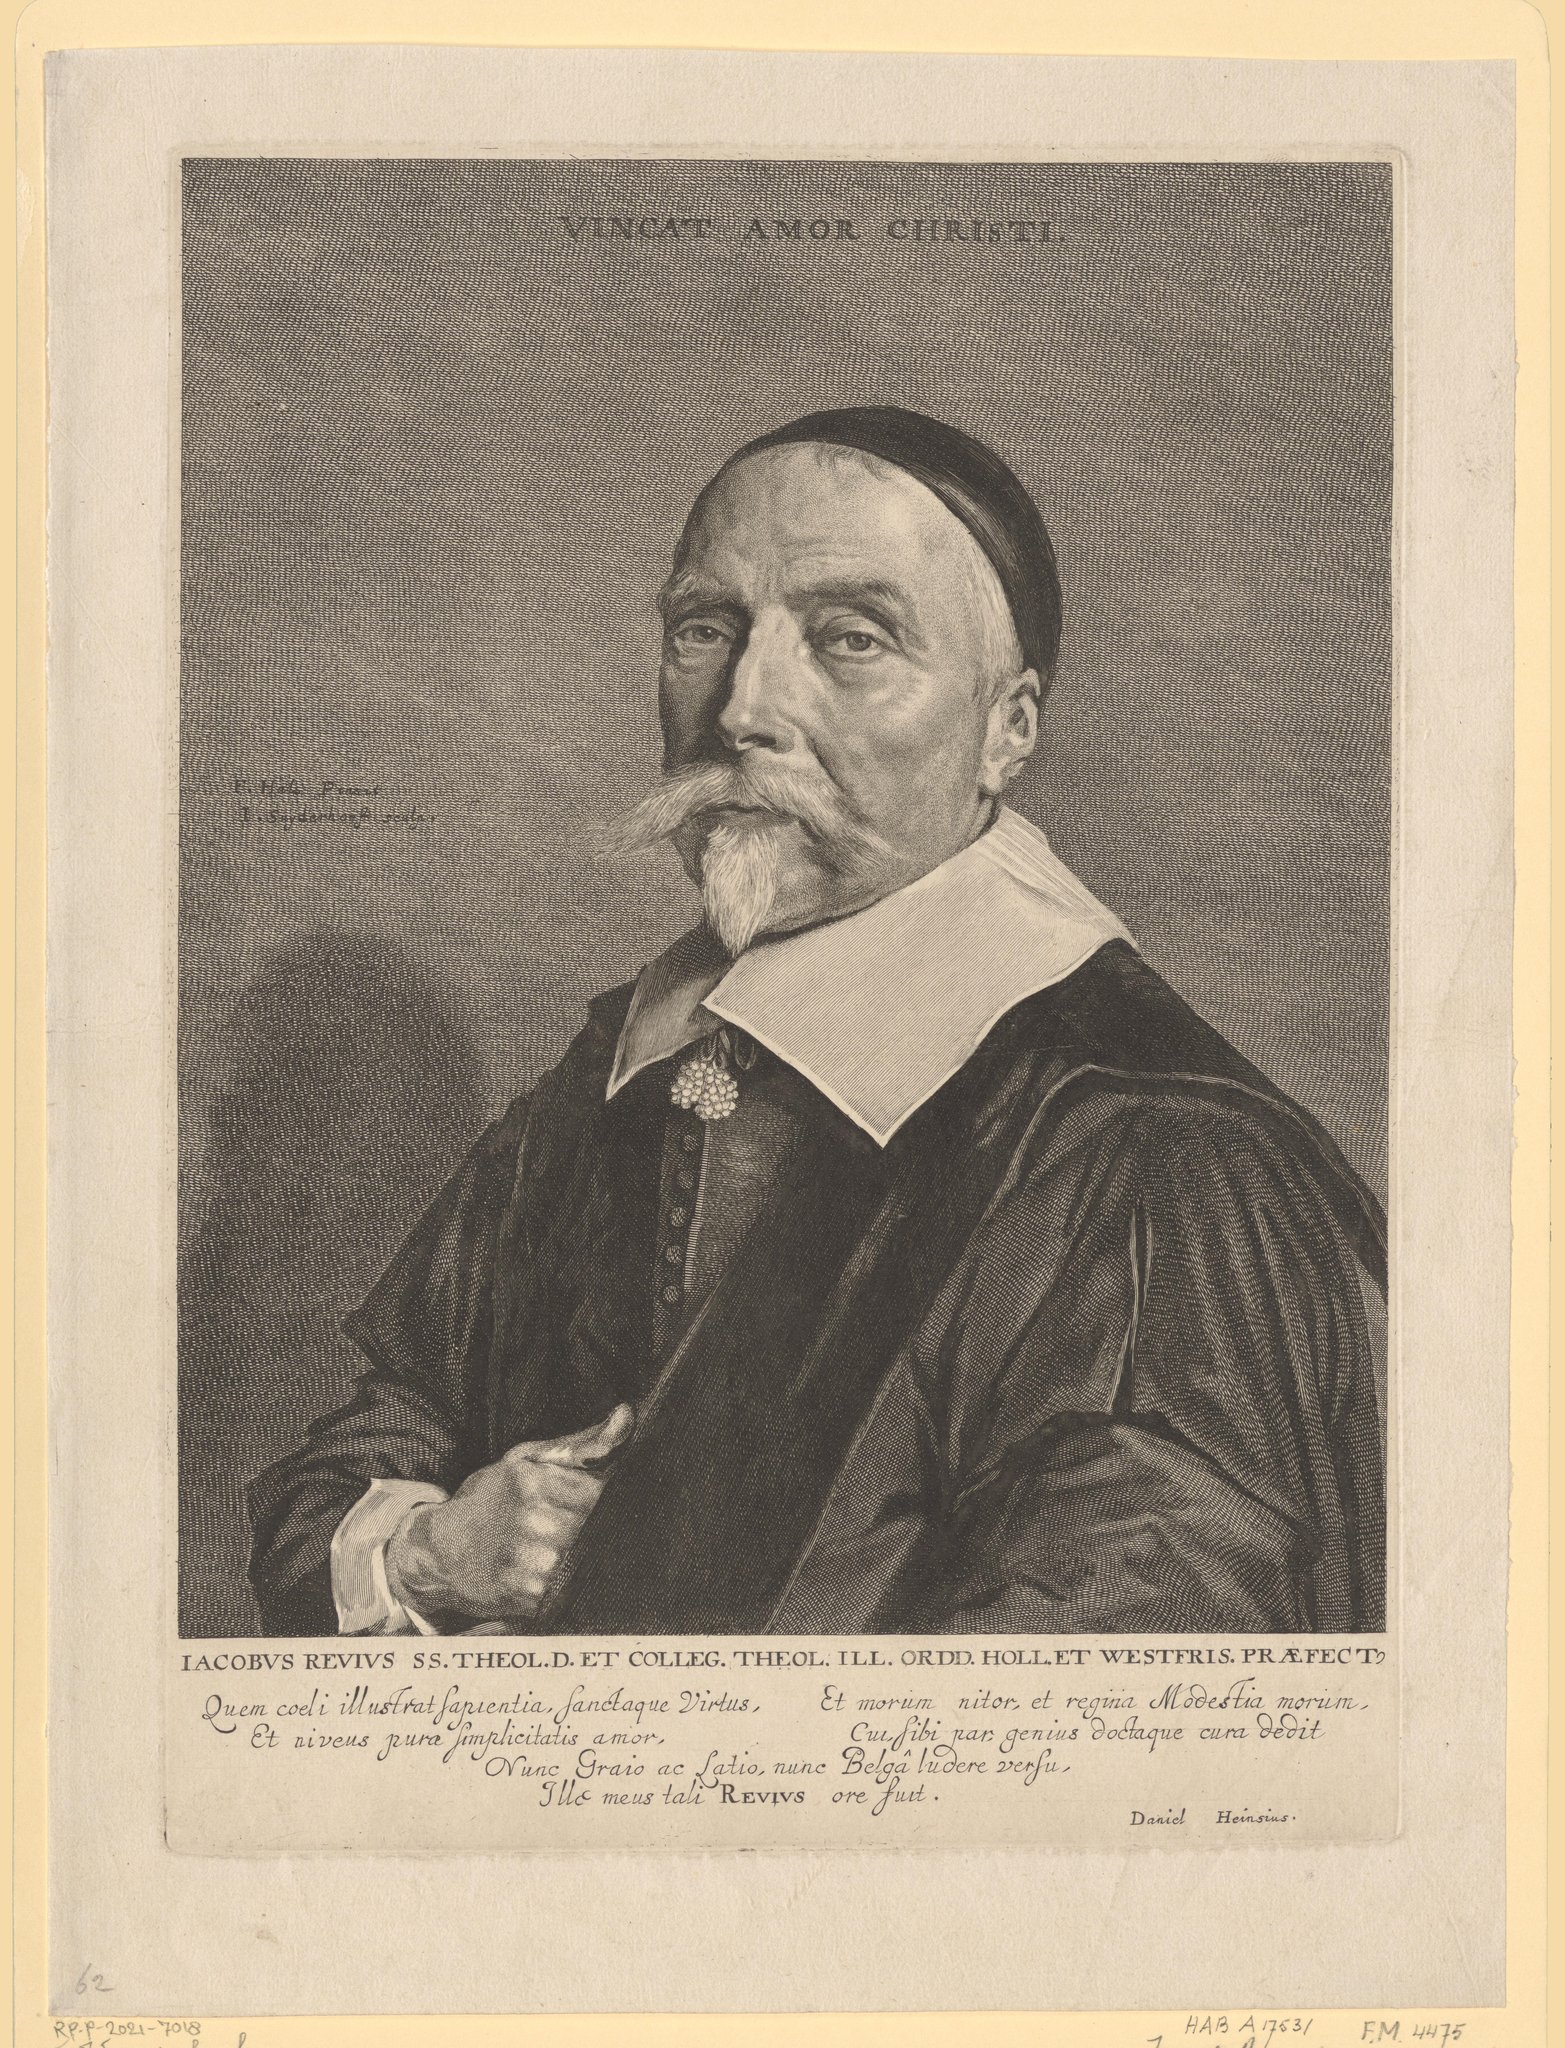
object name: print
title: Portret van Jacobus Revius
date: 1623-1686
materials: paper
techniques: etching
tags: deventer, leiden, historical persons